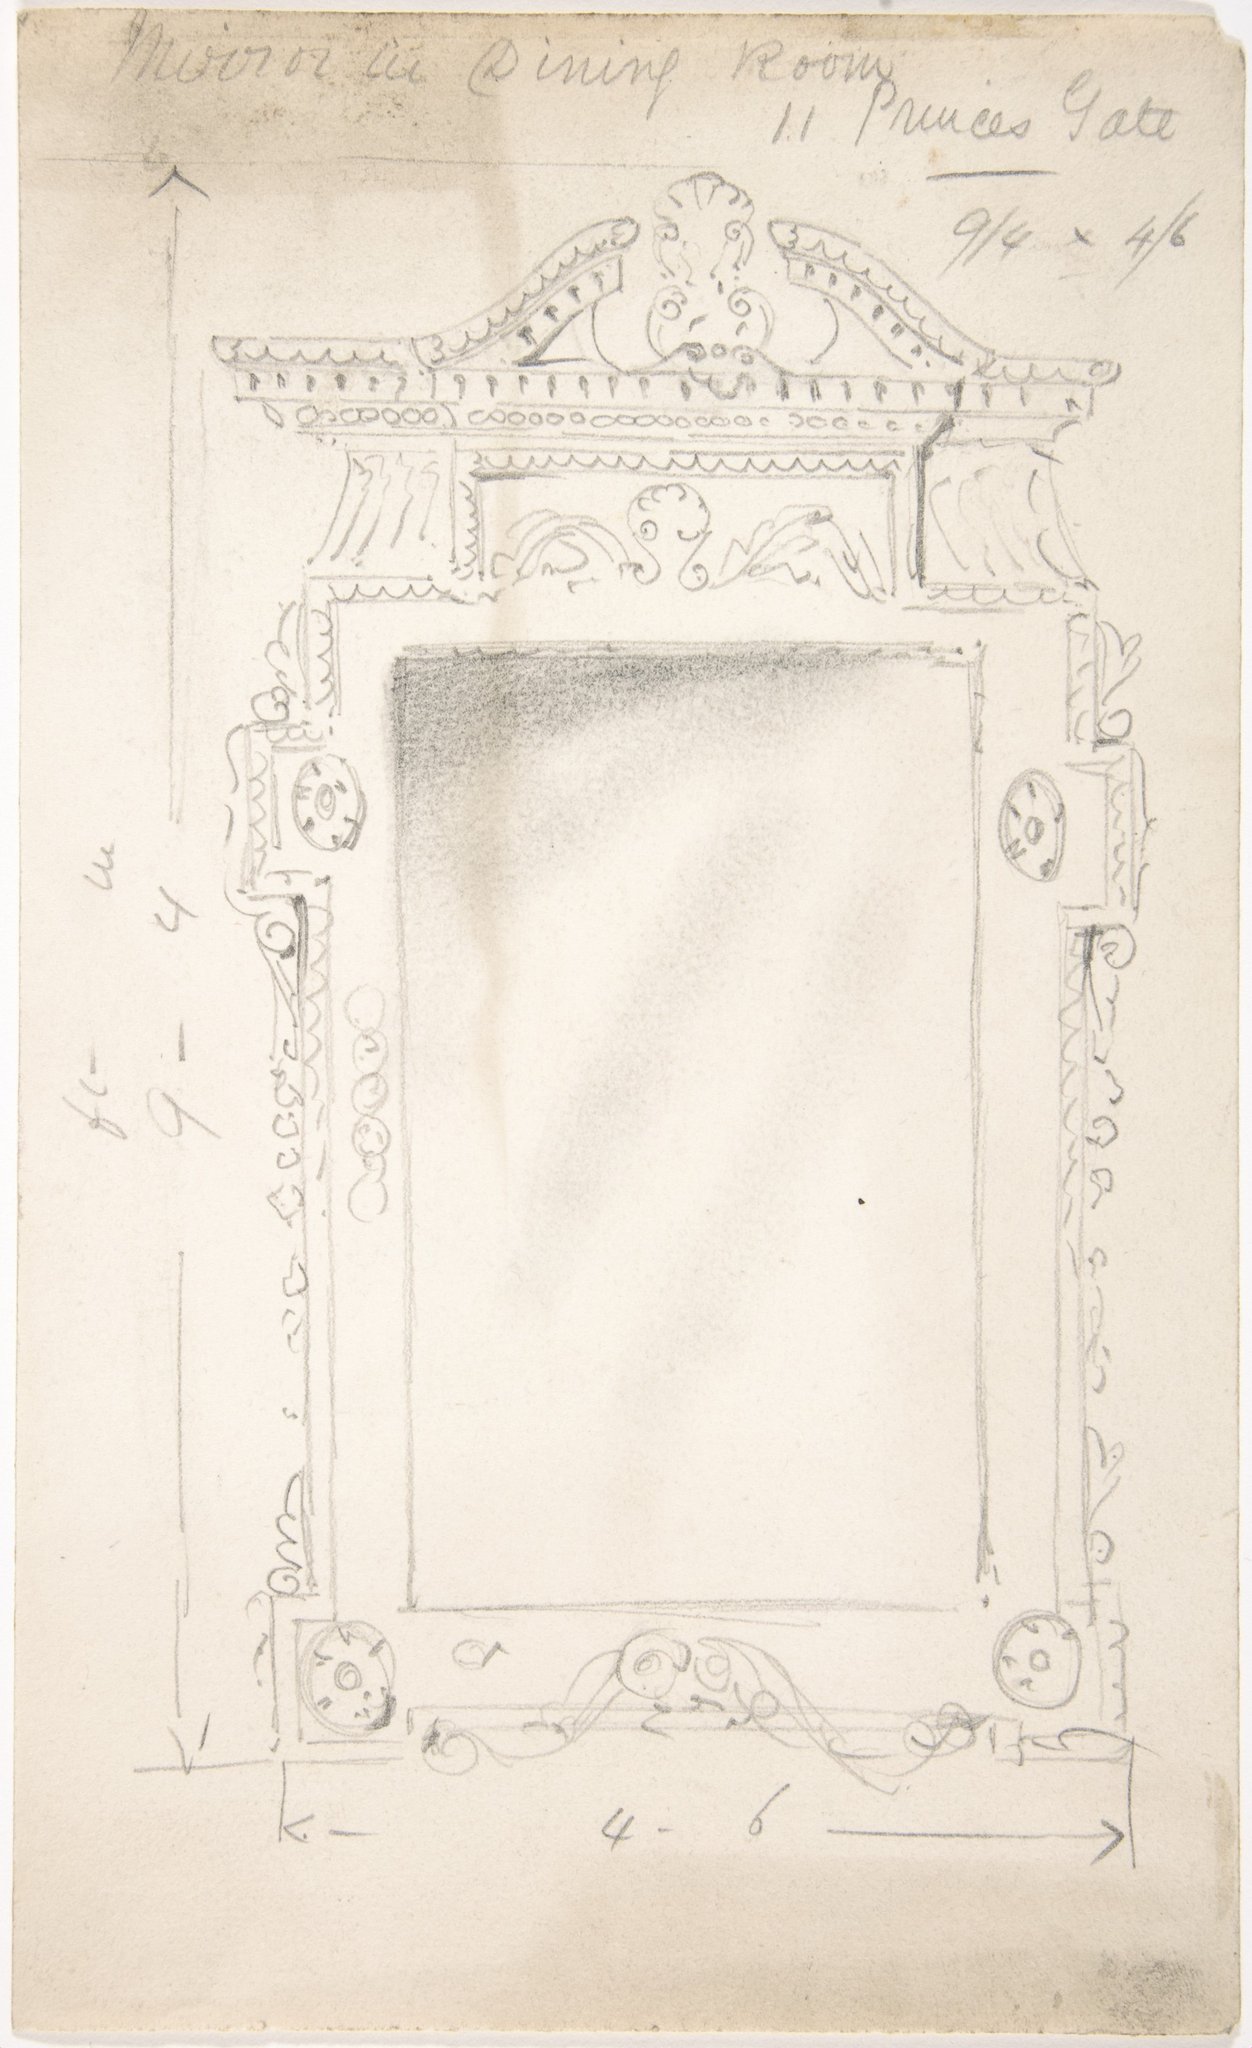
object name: drawing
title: Design for a Dining Room Mirror, for 11 Princes Gate, London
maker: anonymous, british, 19th century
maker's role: artist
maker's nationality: british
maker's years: 1800-1900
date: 1801-1900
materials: graphite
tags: mirrors